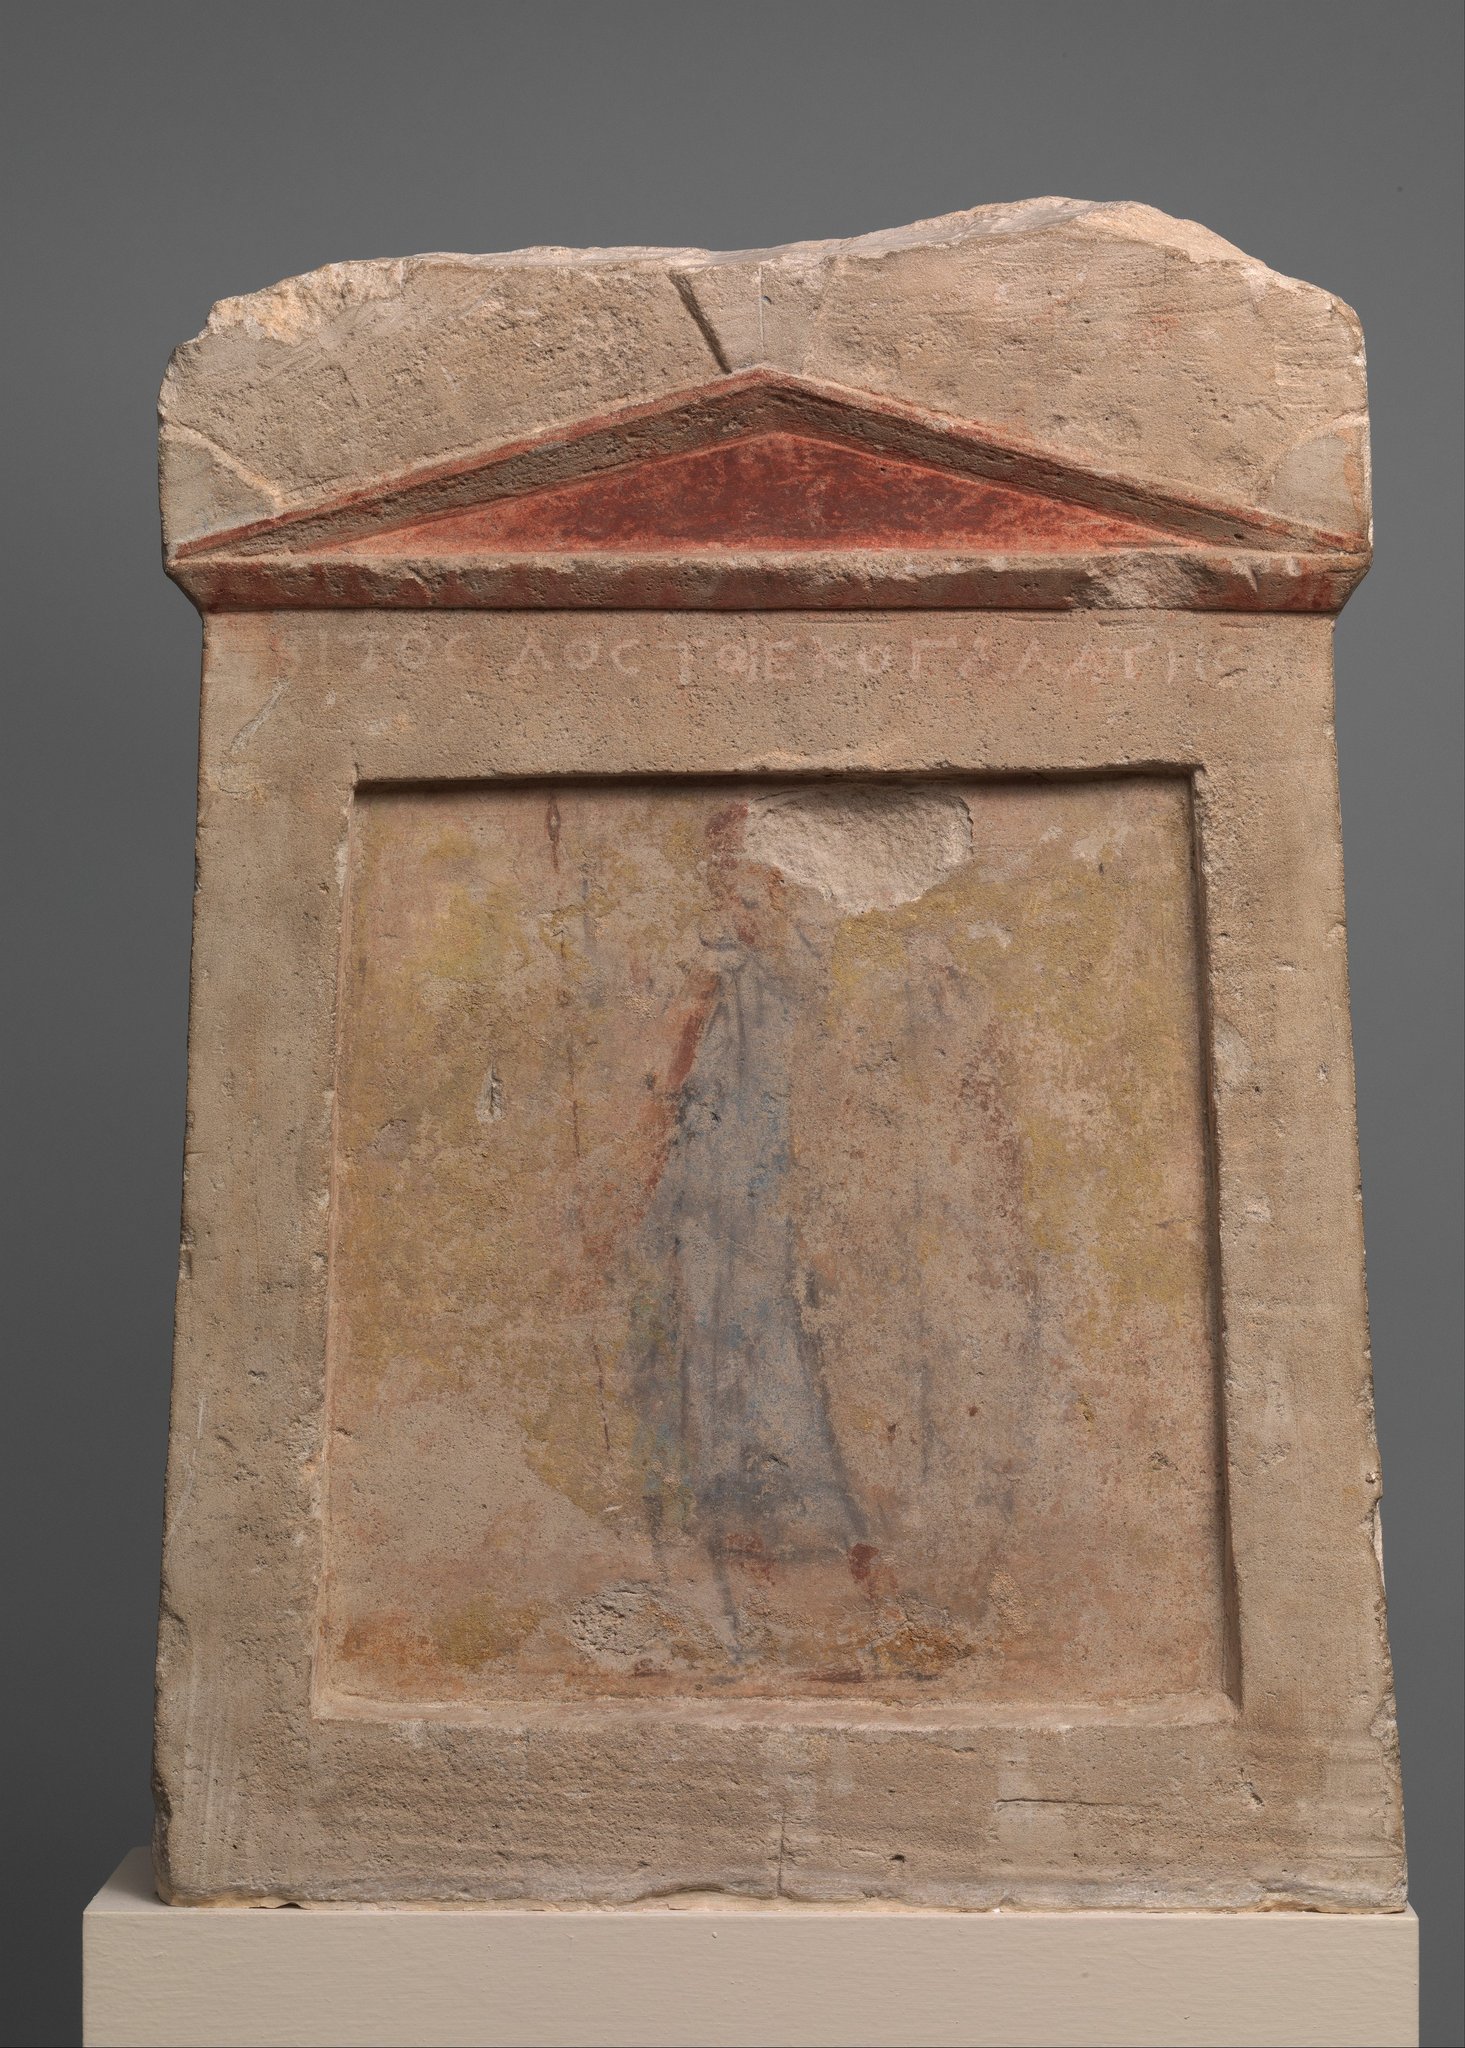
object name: grave stele, painted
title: Painted limestone funerary slab with a soldier standing at ease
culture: greek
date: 250-201 BCE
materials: limestone, paint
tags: soldiers,men